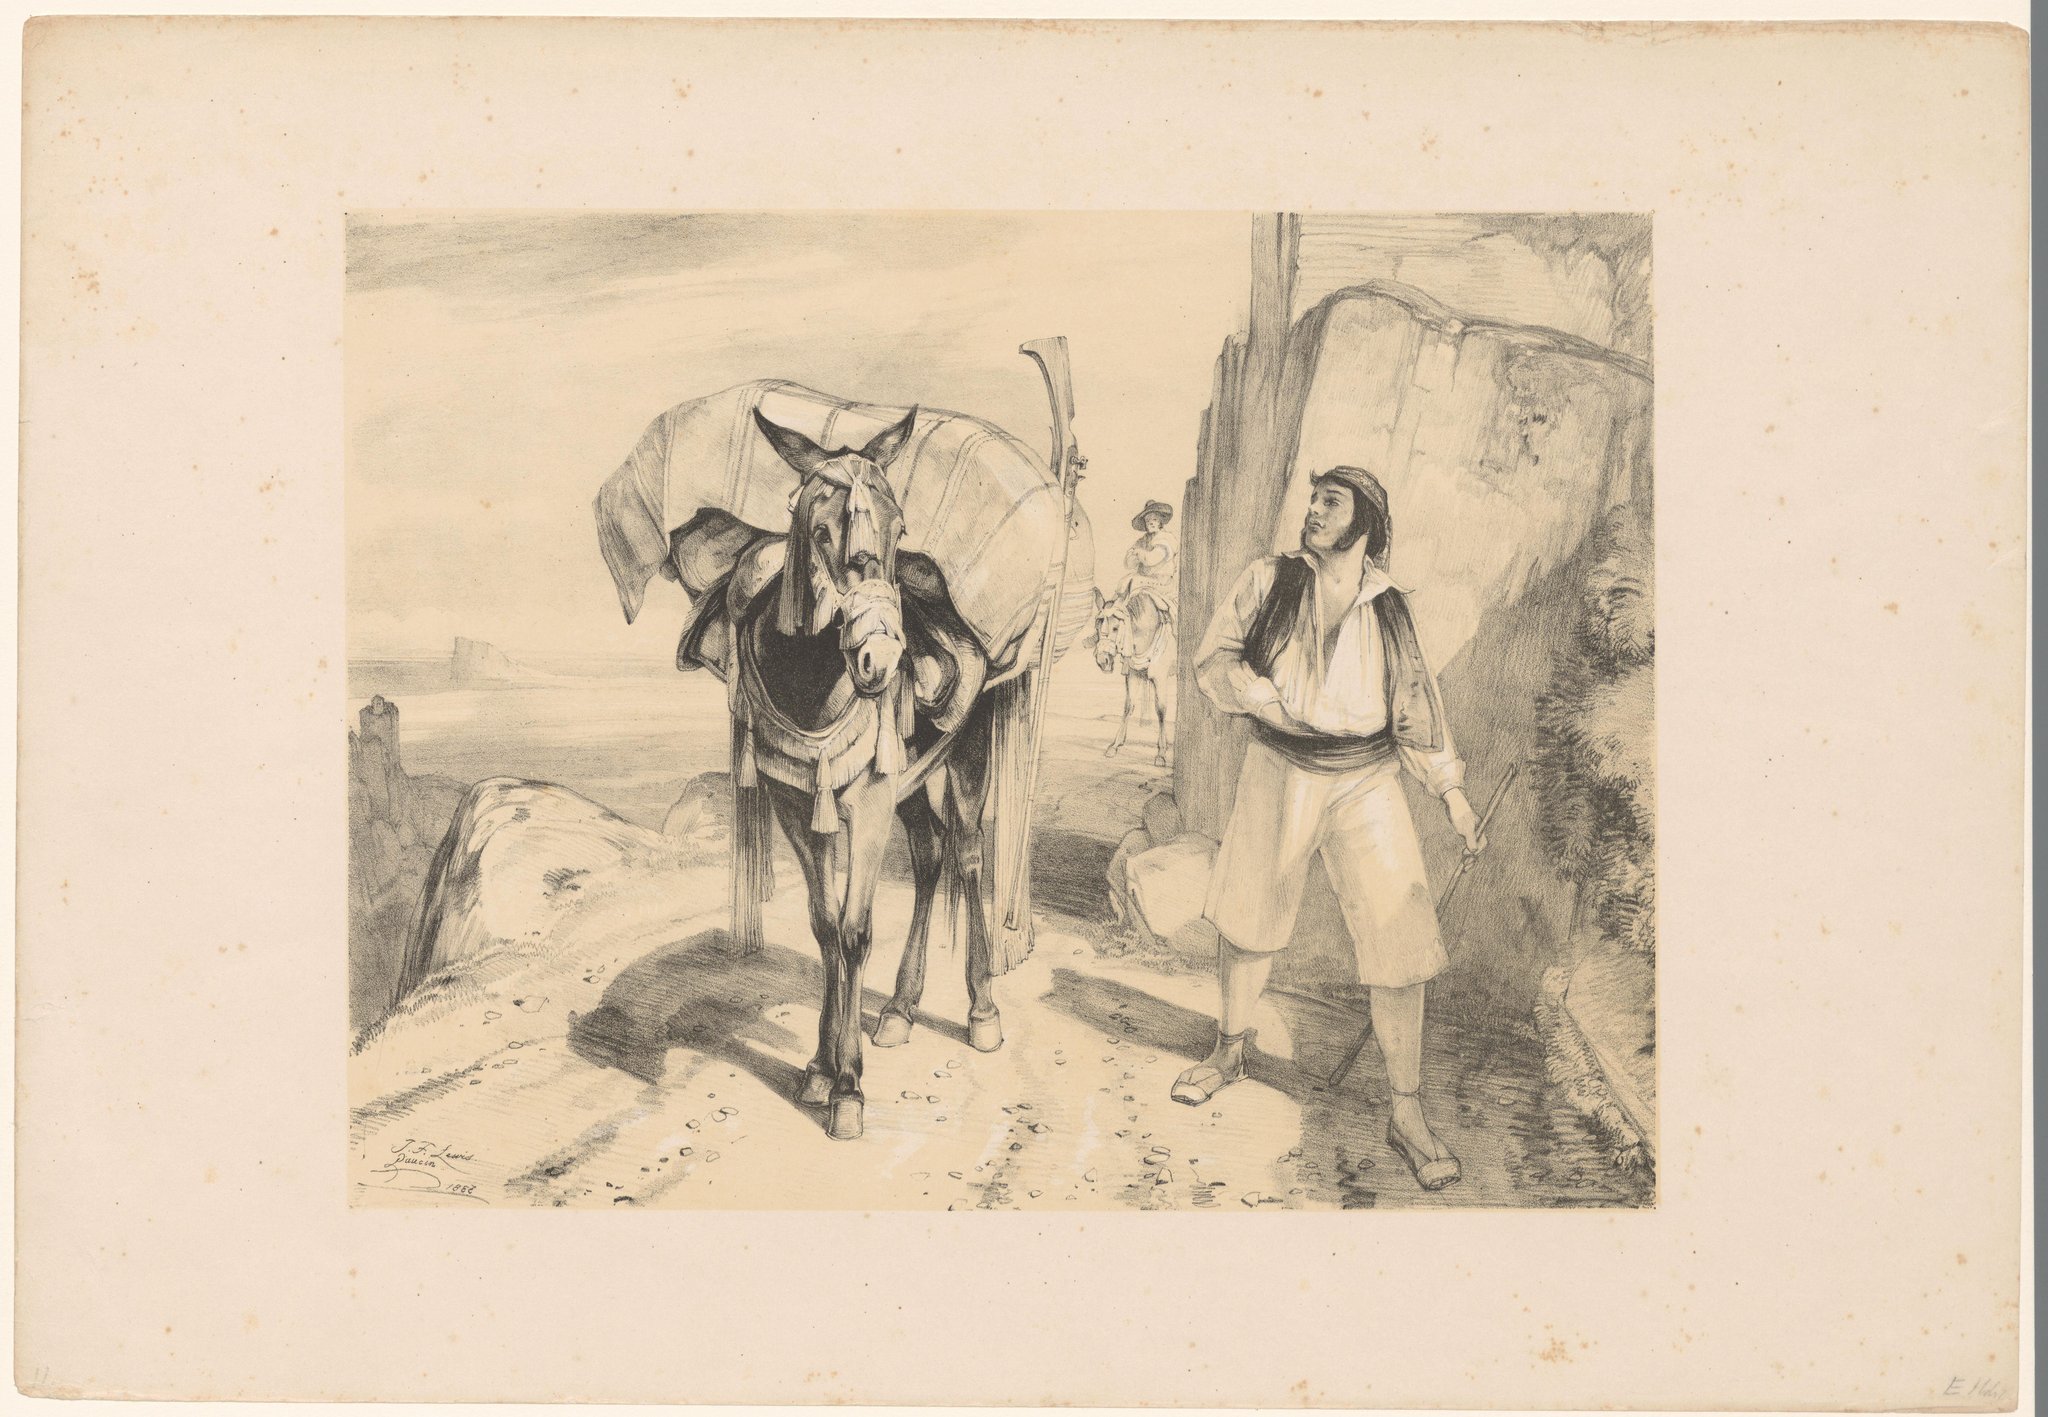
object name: print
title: Taferelen uit Spanje met Spaanse figuren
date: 1836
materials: paper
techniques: tone lithography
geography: london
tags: riding a horse, ass, or mule; rider, horseman, smuggler, 'en route', traveller under way, spain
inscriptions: collector's mark: Lugt 2228